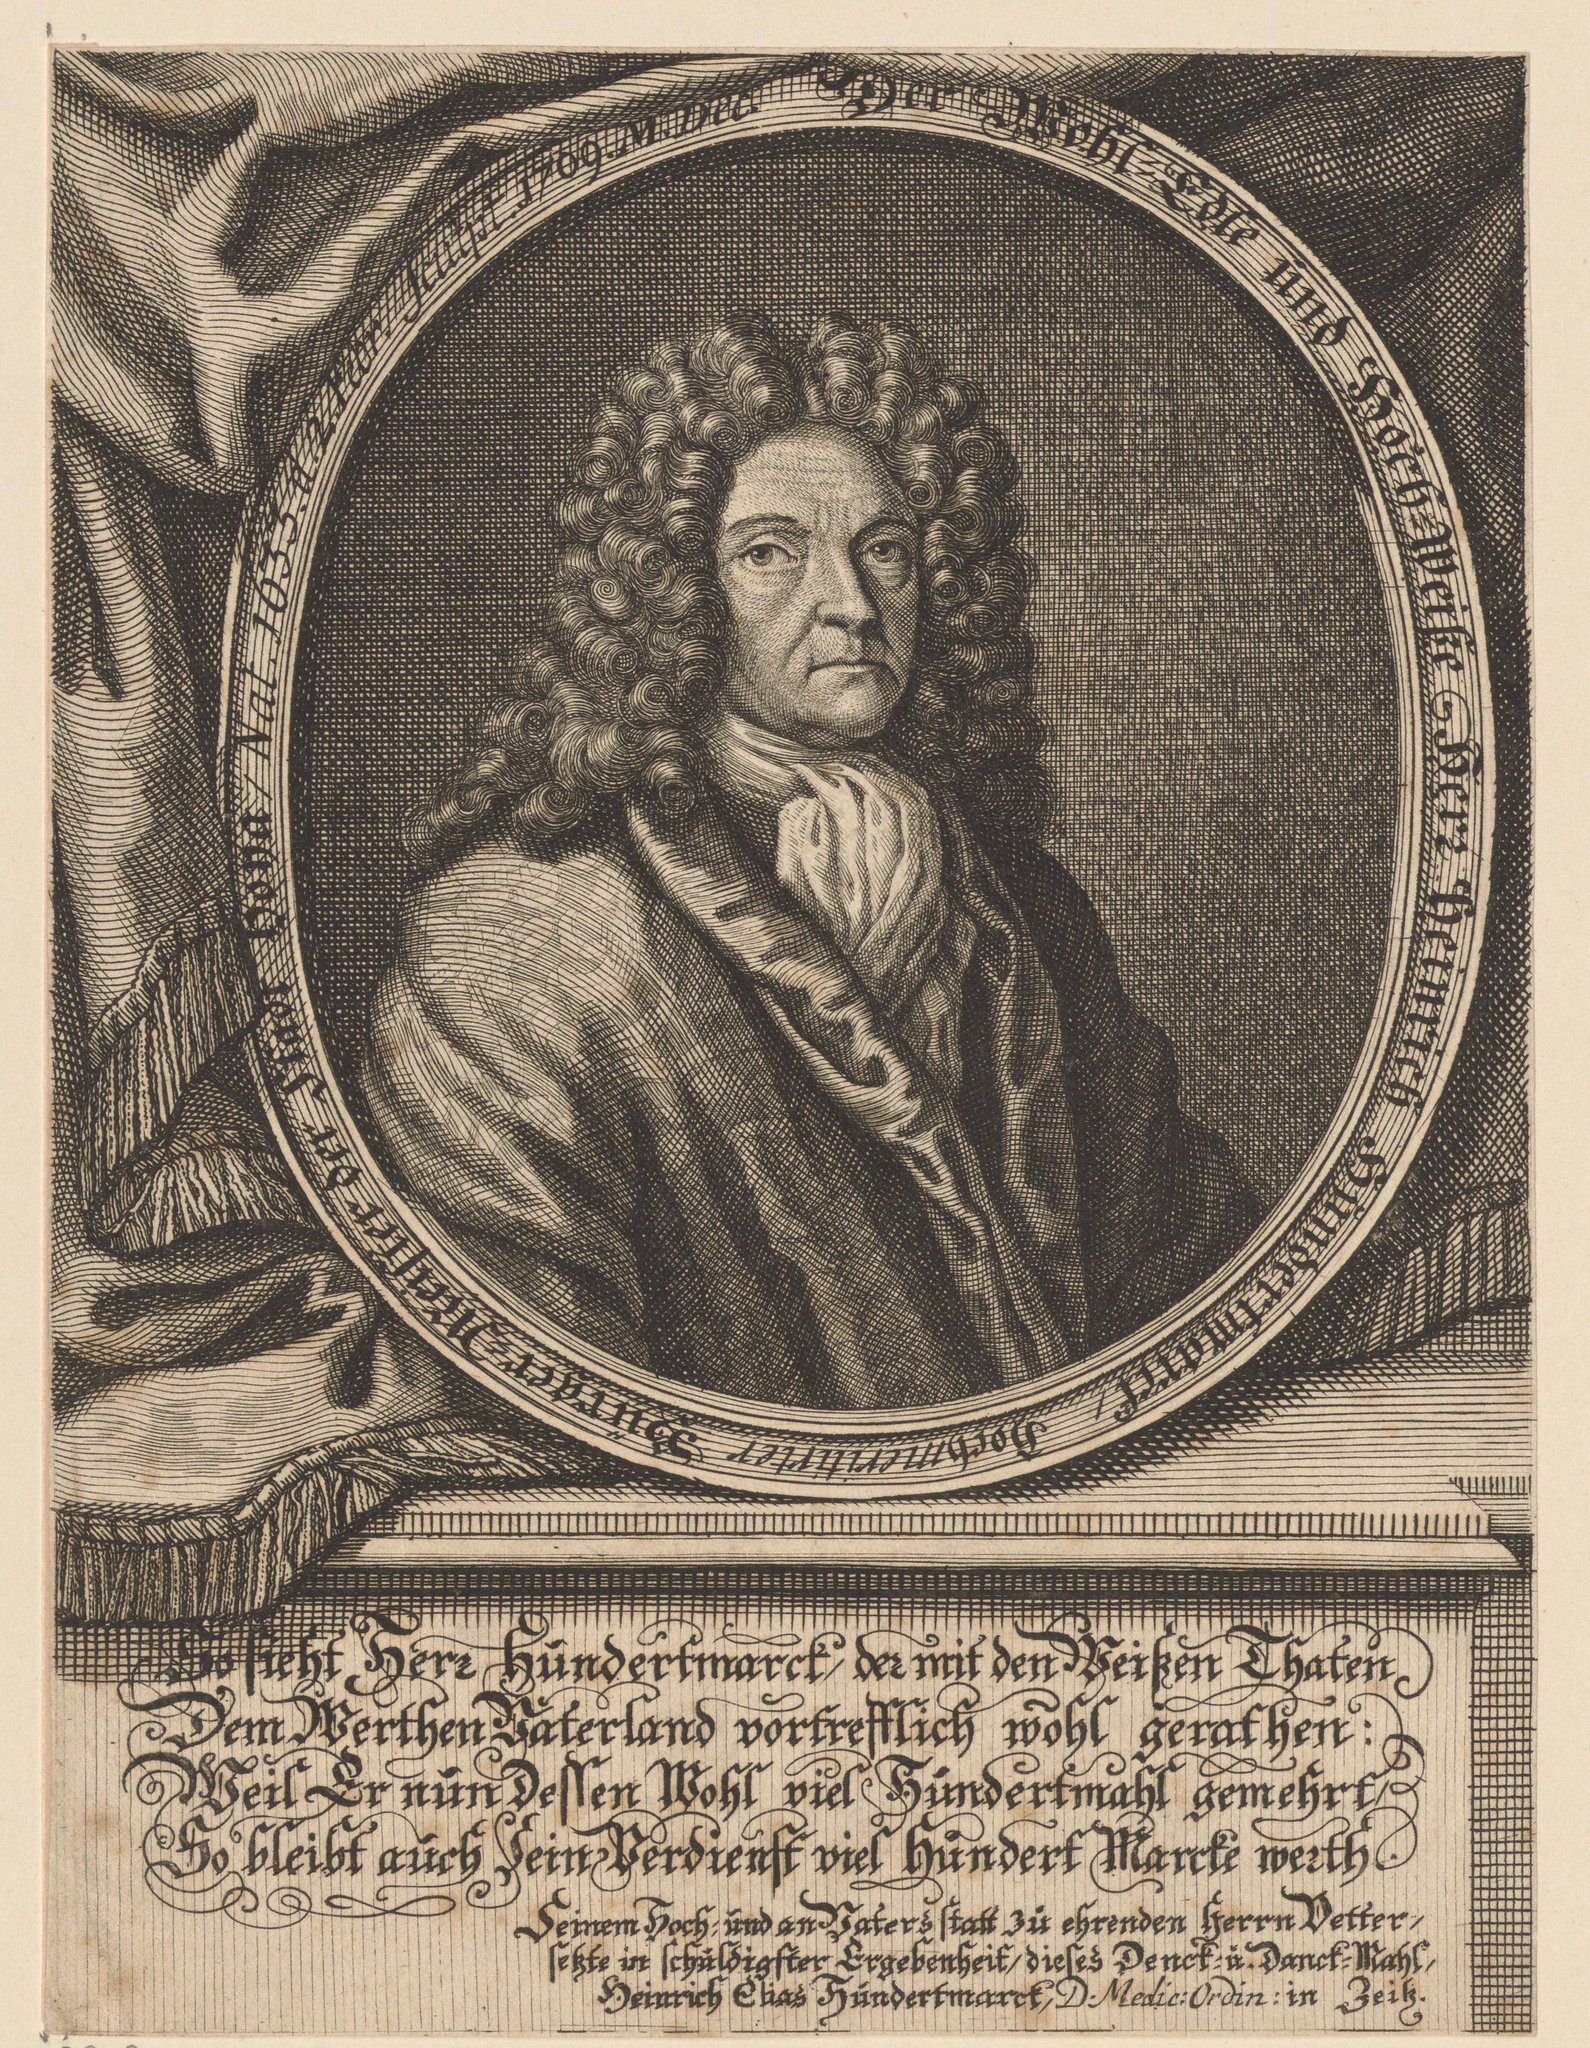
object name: print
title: Portret van Heinrich Hundertmark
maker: Anonymous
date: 1709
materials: paper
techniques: engraving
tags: mayor, burgomaster, historical persons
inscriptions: date